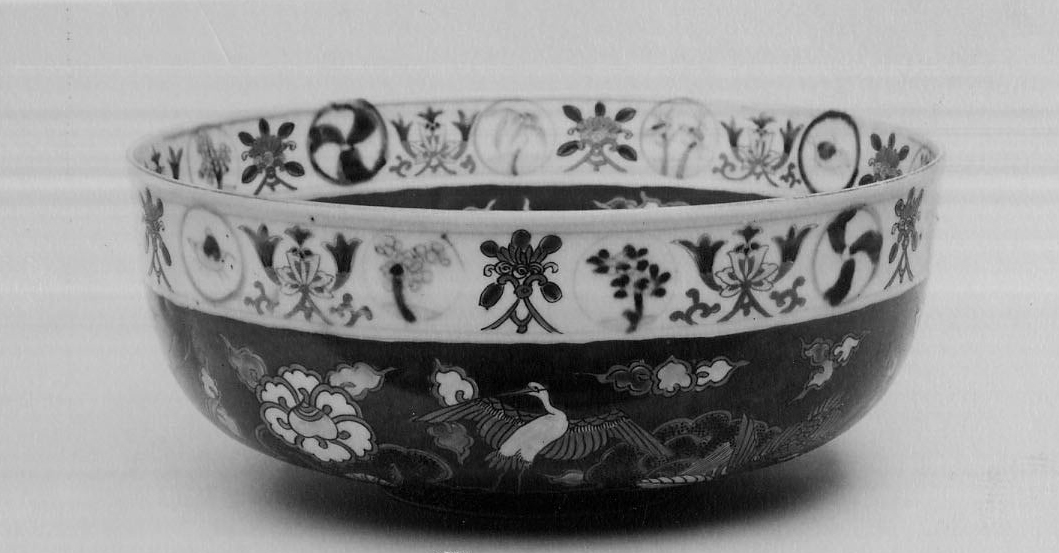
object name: bowl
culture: japanese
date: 1701-1900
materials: gilt, porcelain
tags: birds,flowers